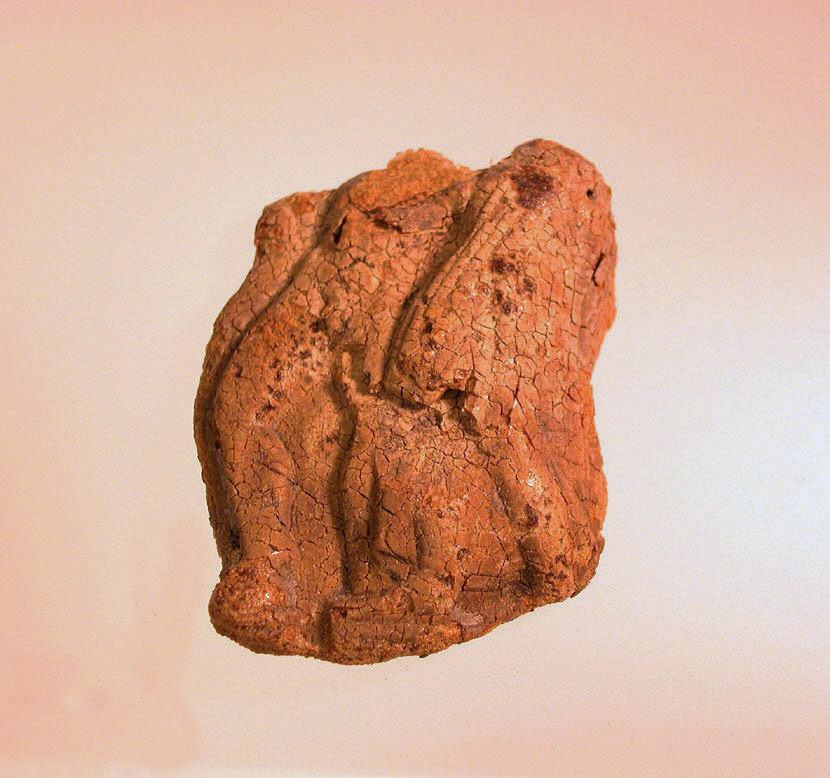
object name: two figure dancing to left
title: Two figures dancing?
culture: etruscan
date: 500-401 BCE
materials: amber